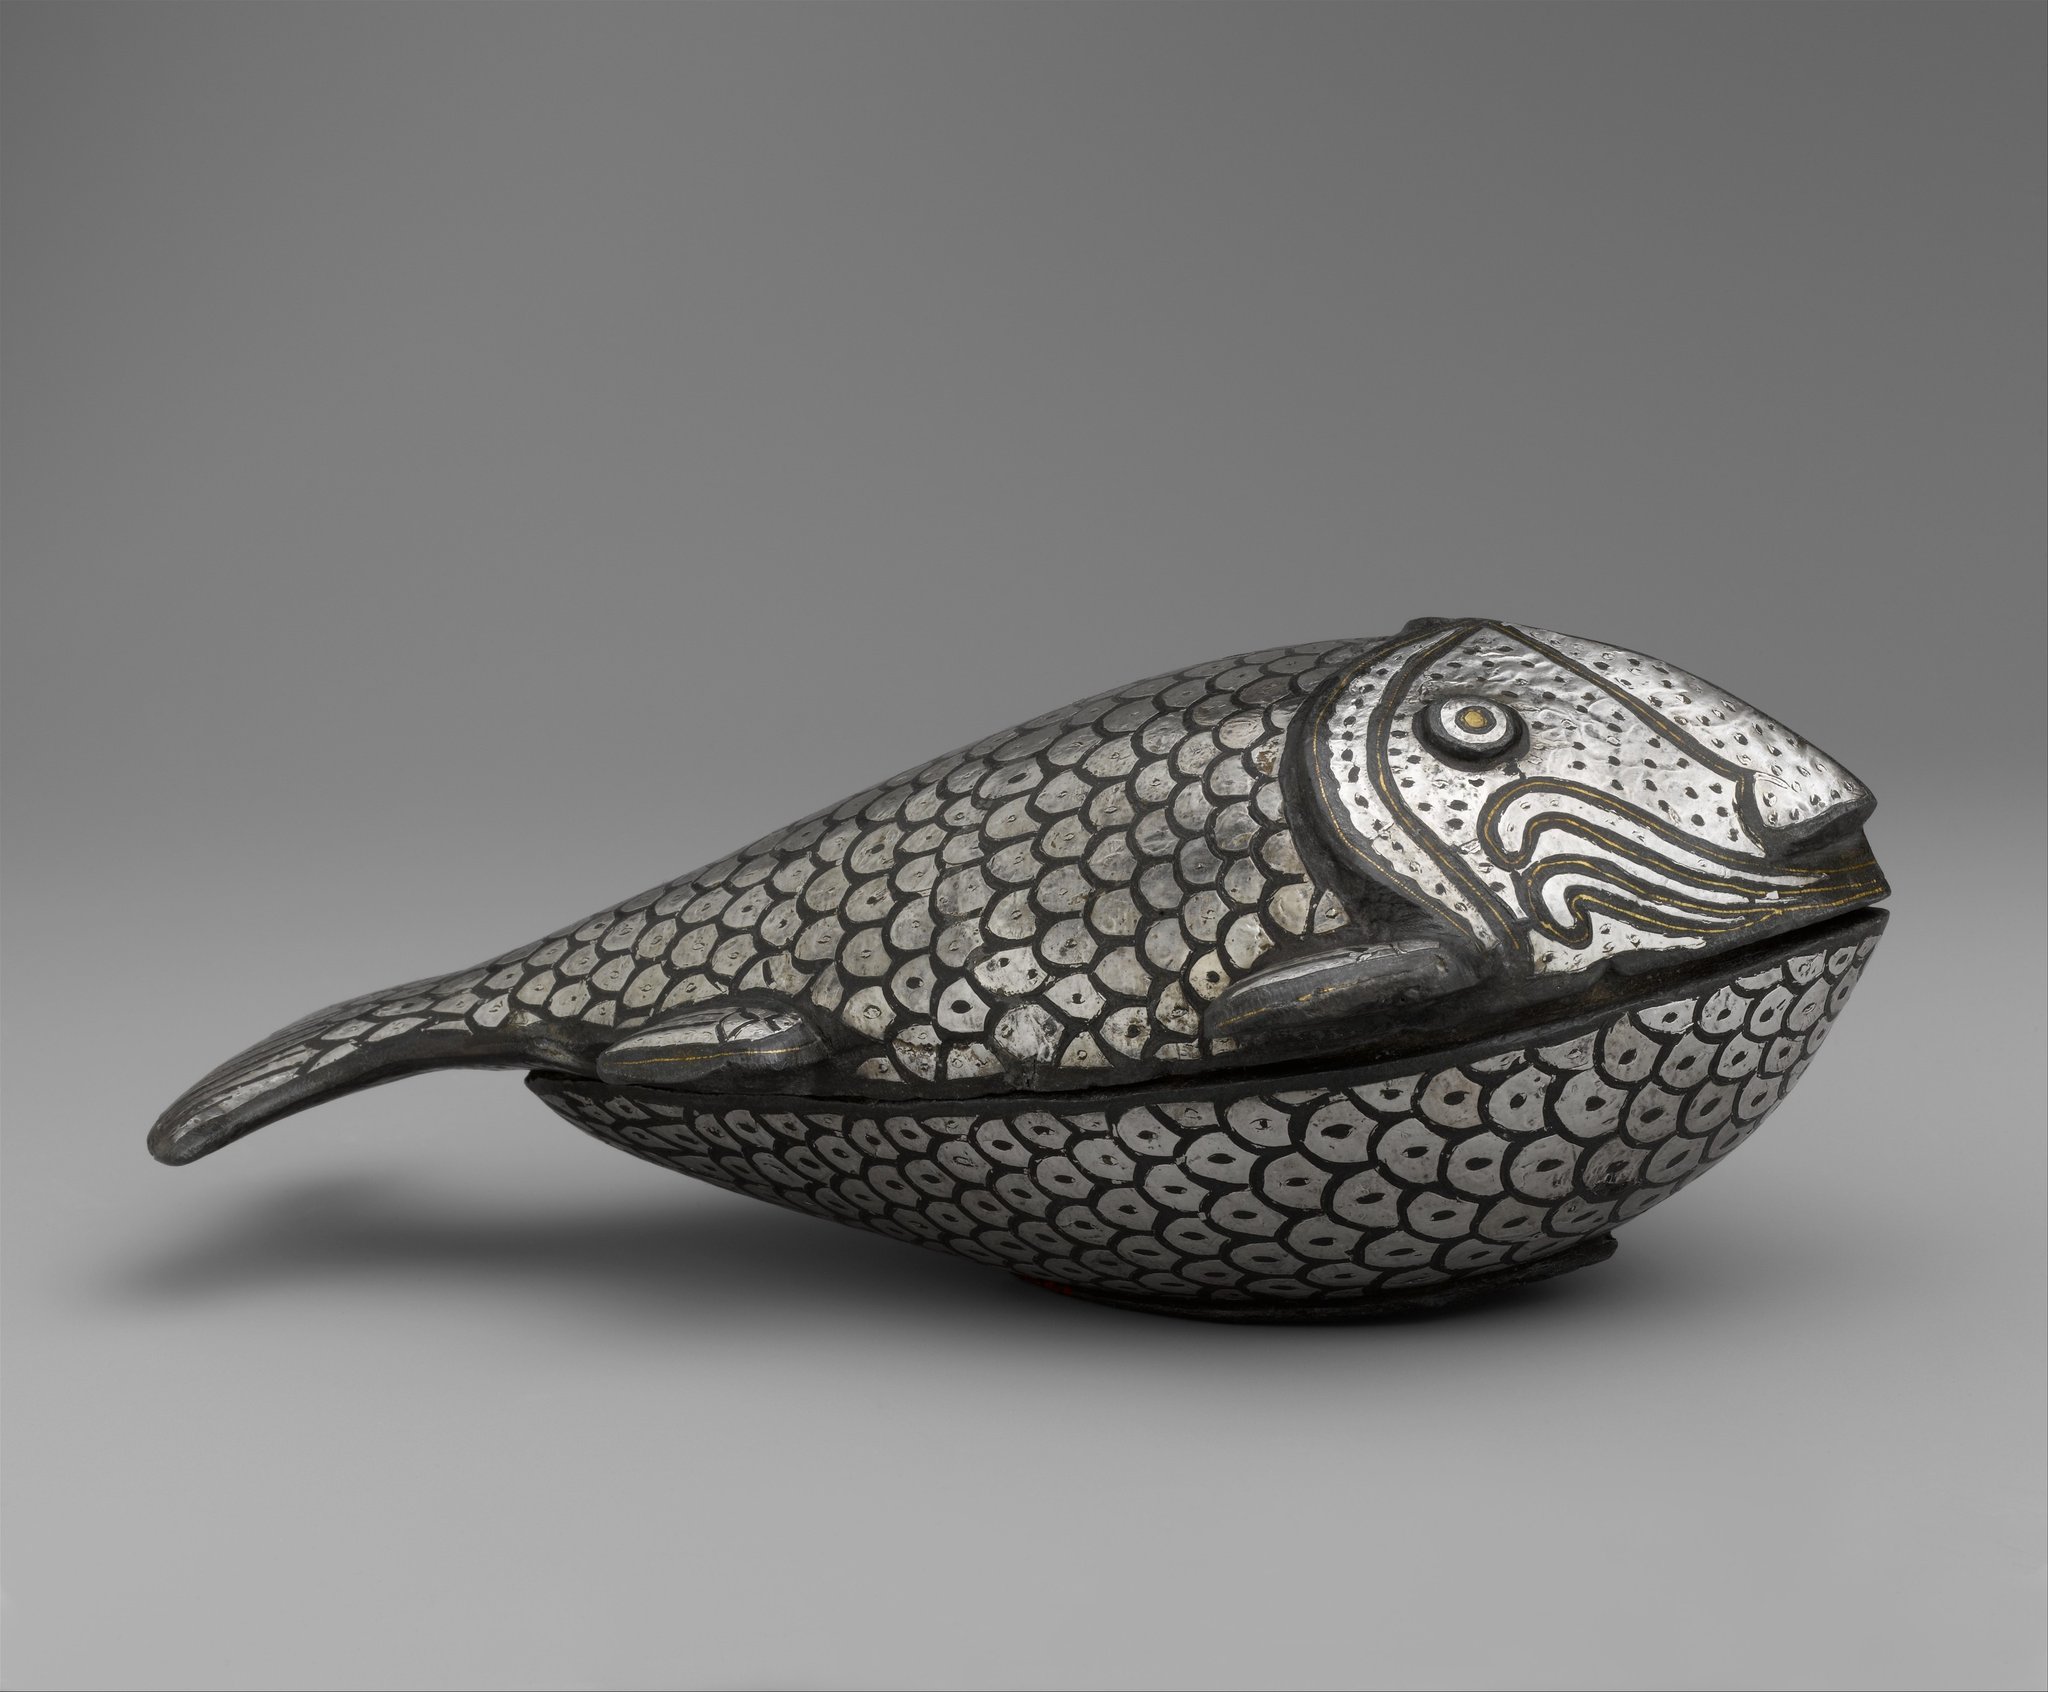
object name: box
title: Fish-Shaped Box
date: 1801-1900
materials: alloy, brass, silver, zinc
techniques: casting, engraving, inlay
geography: india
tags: fish